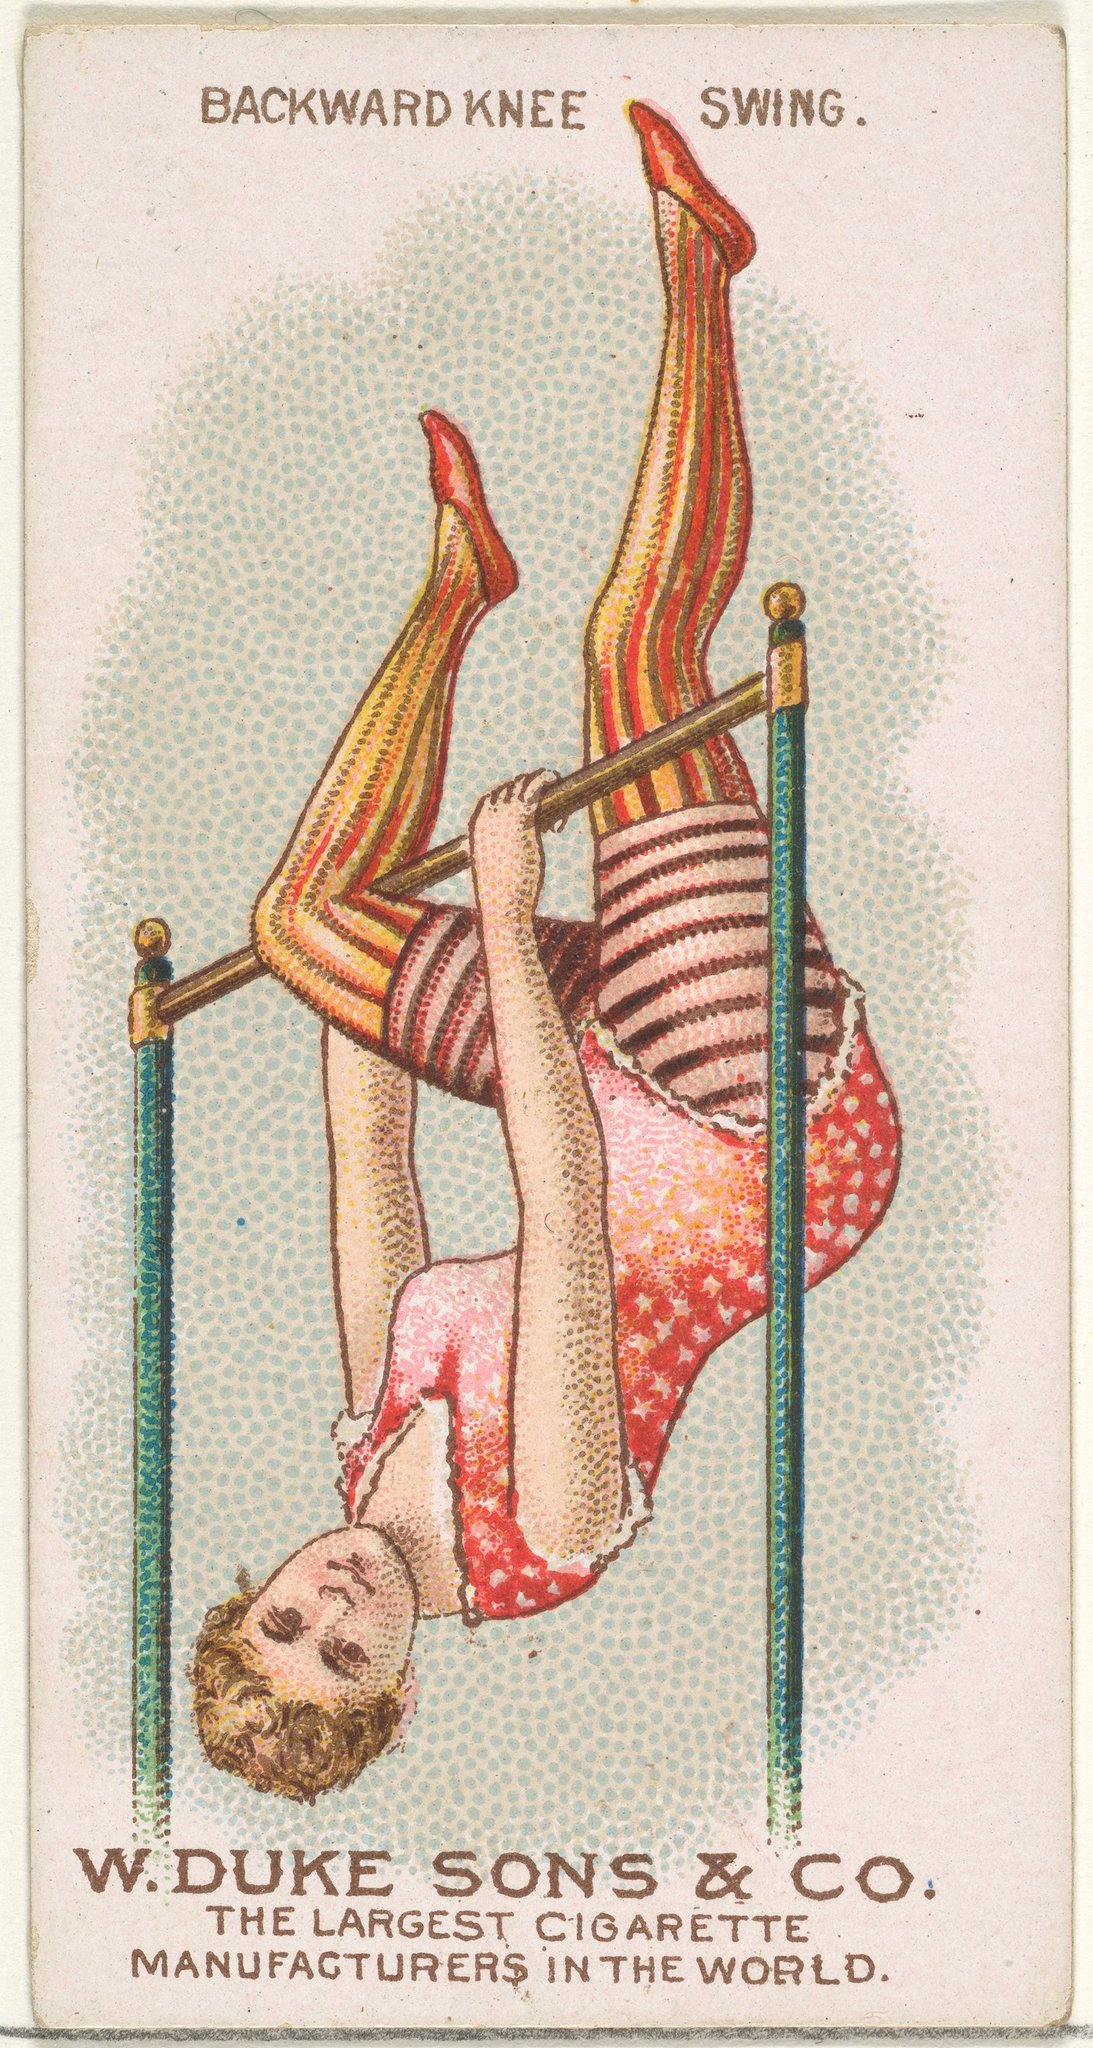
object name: print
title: Backward Knee Swing, from the Gymnastic Exercises series (N77) for Duke brand cigarettes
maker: w. duke, sons & co.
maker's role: publisher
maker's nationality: american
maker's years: 1870-1920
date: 1887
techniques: color lithograph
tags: women,athletes